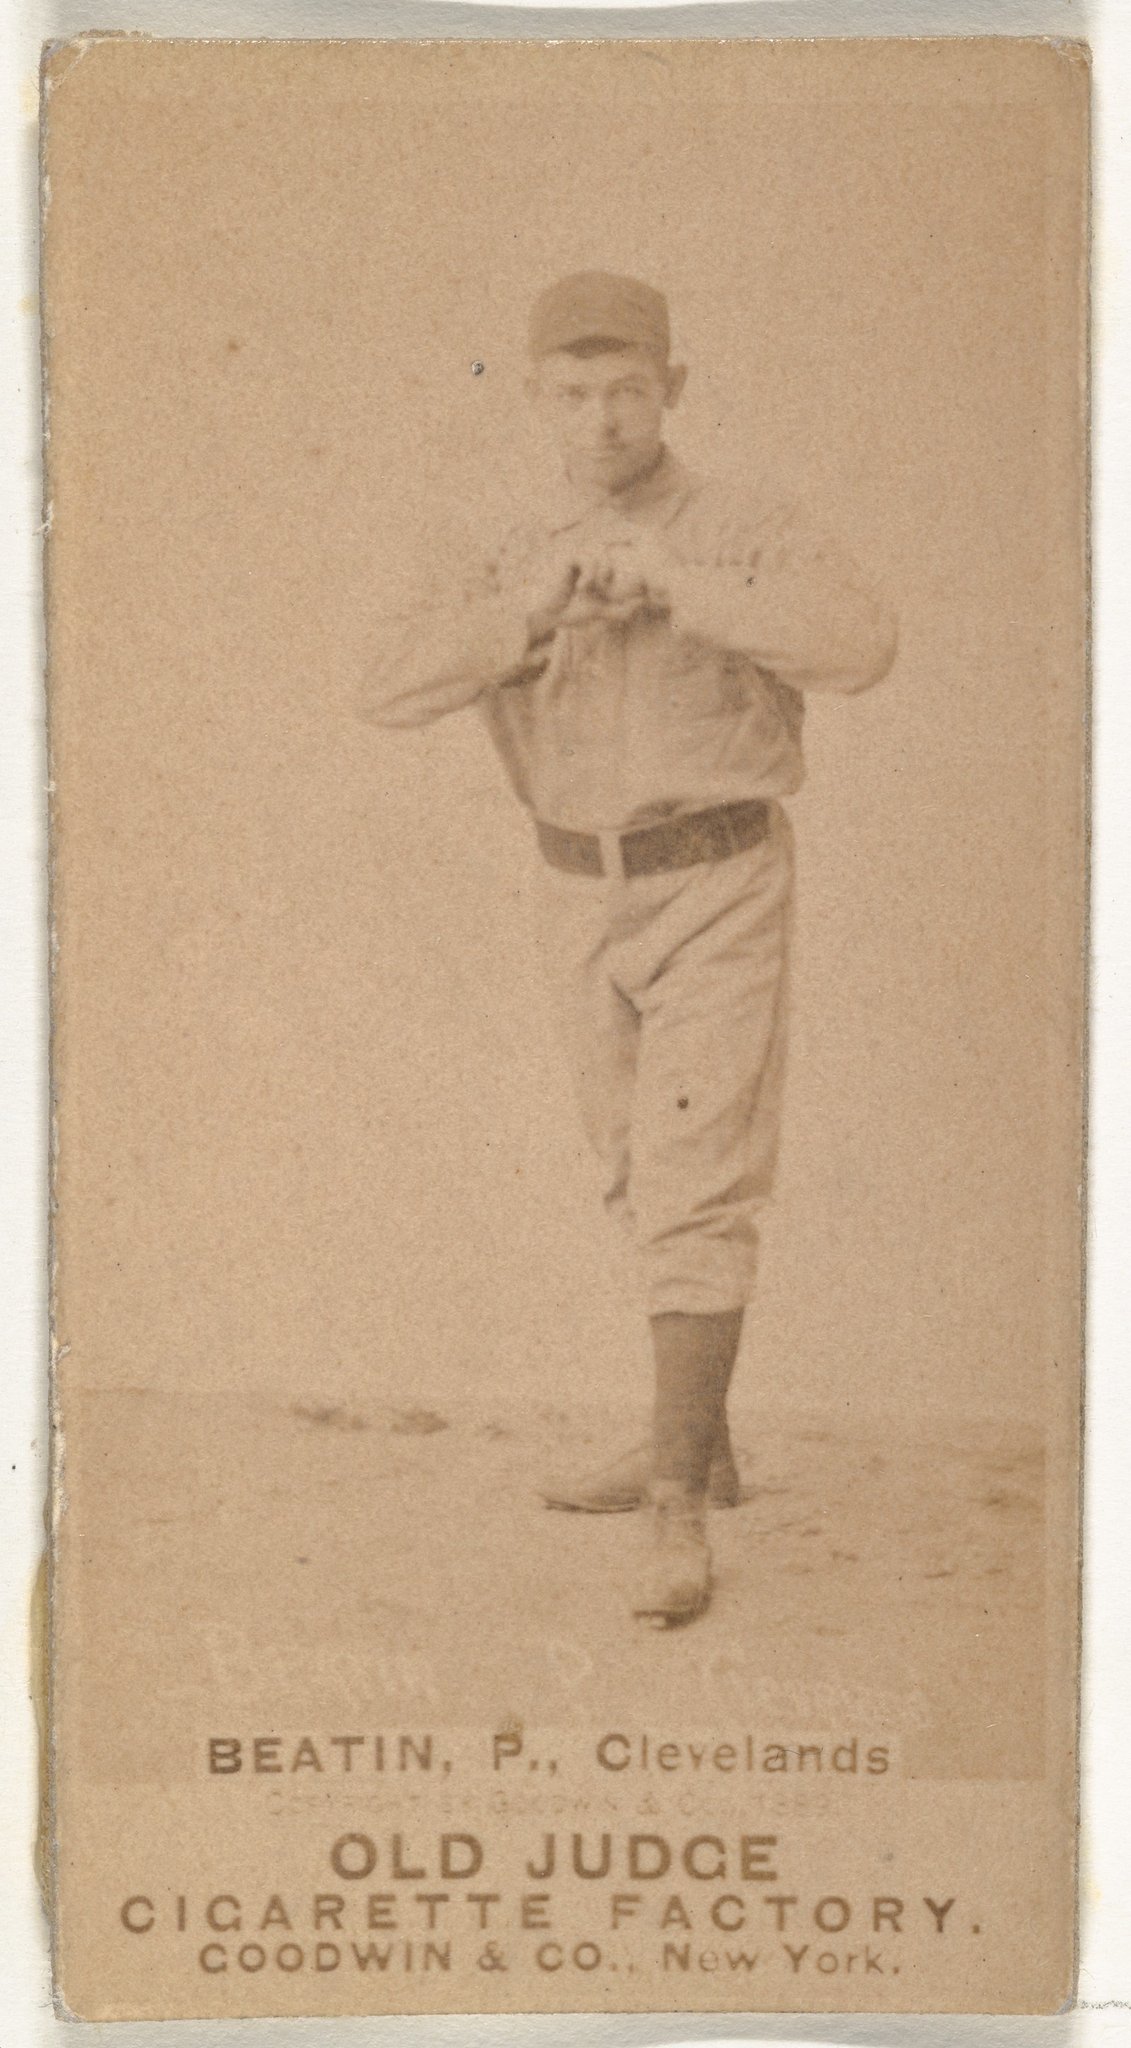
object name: baseball card, photograph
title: Ebenezer Ambrose "Ed" Beatin, Pitcher, Cleveland, from the Old Judge series (N172) for Old Judge Cigarettes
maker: goodwin & company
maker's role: publisher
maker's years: 1850-1950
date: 1887-1890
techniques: albumen silver print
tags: men,portraits,baseball,athletes